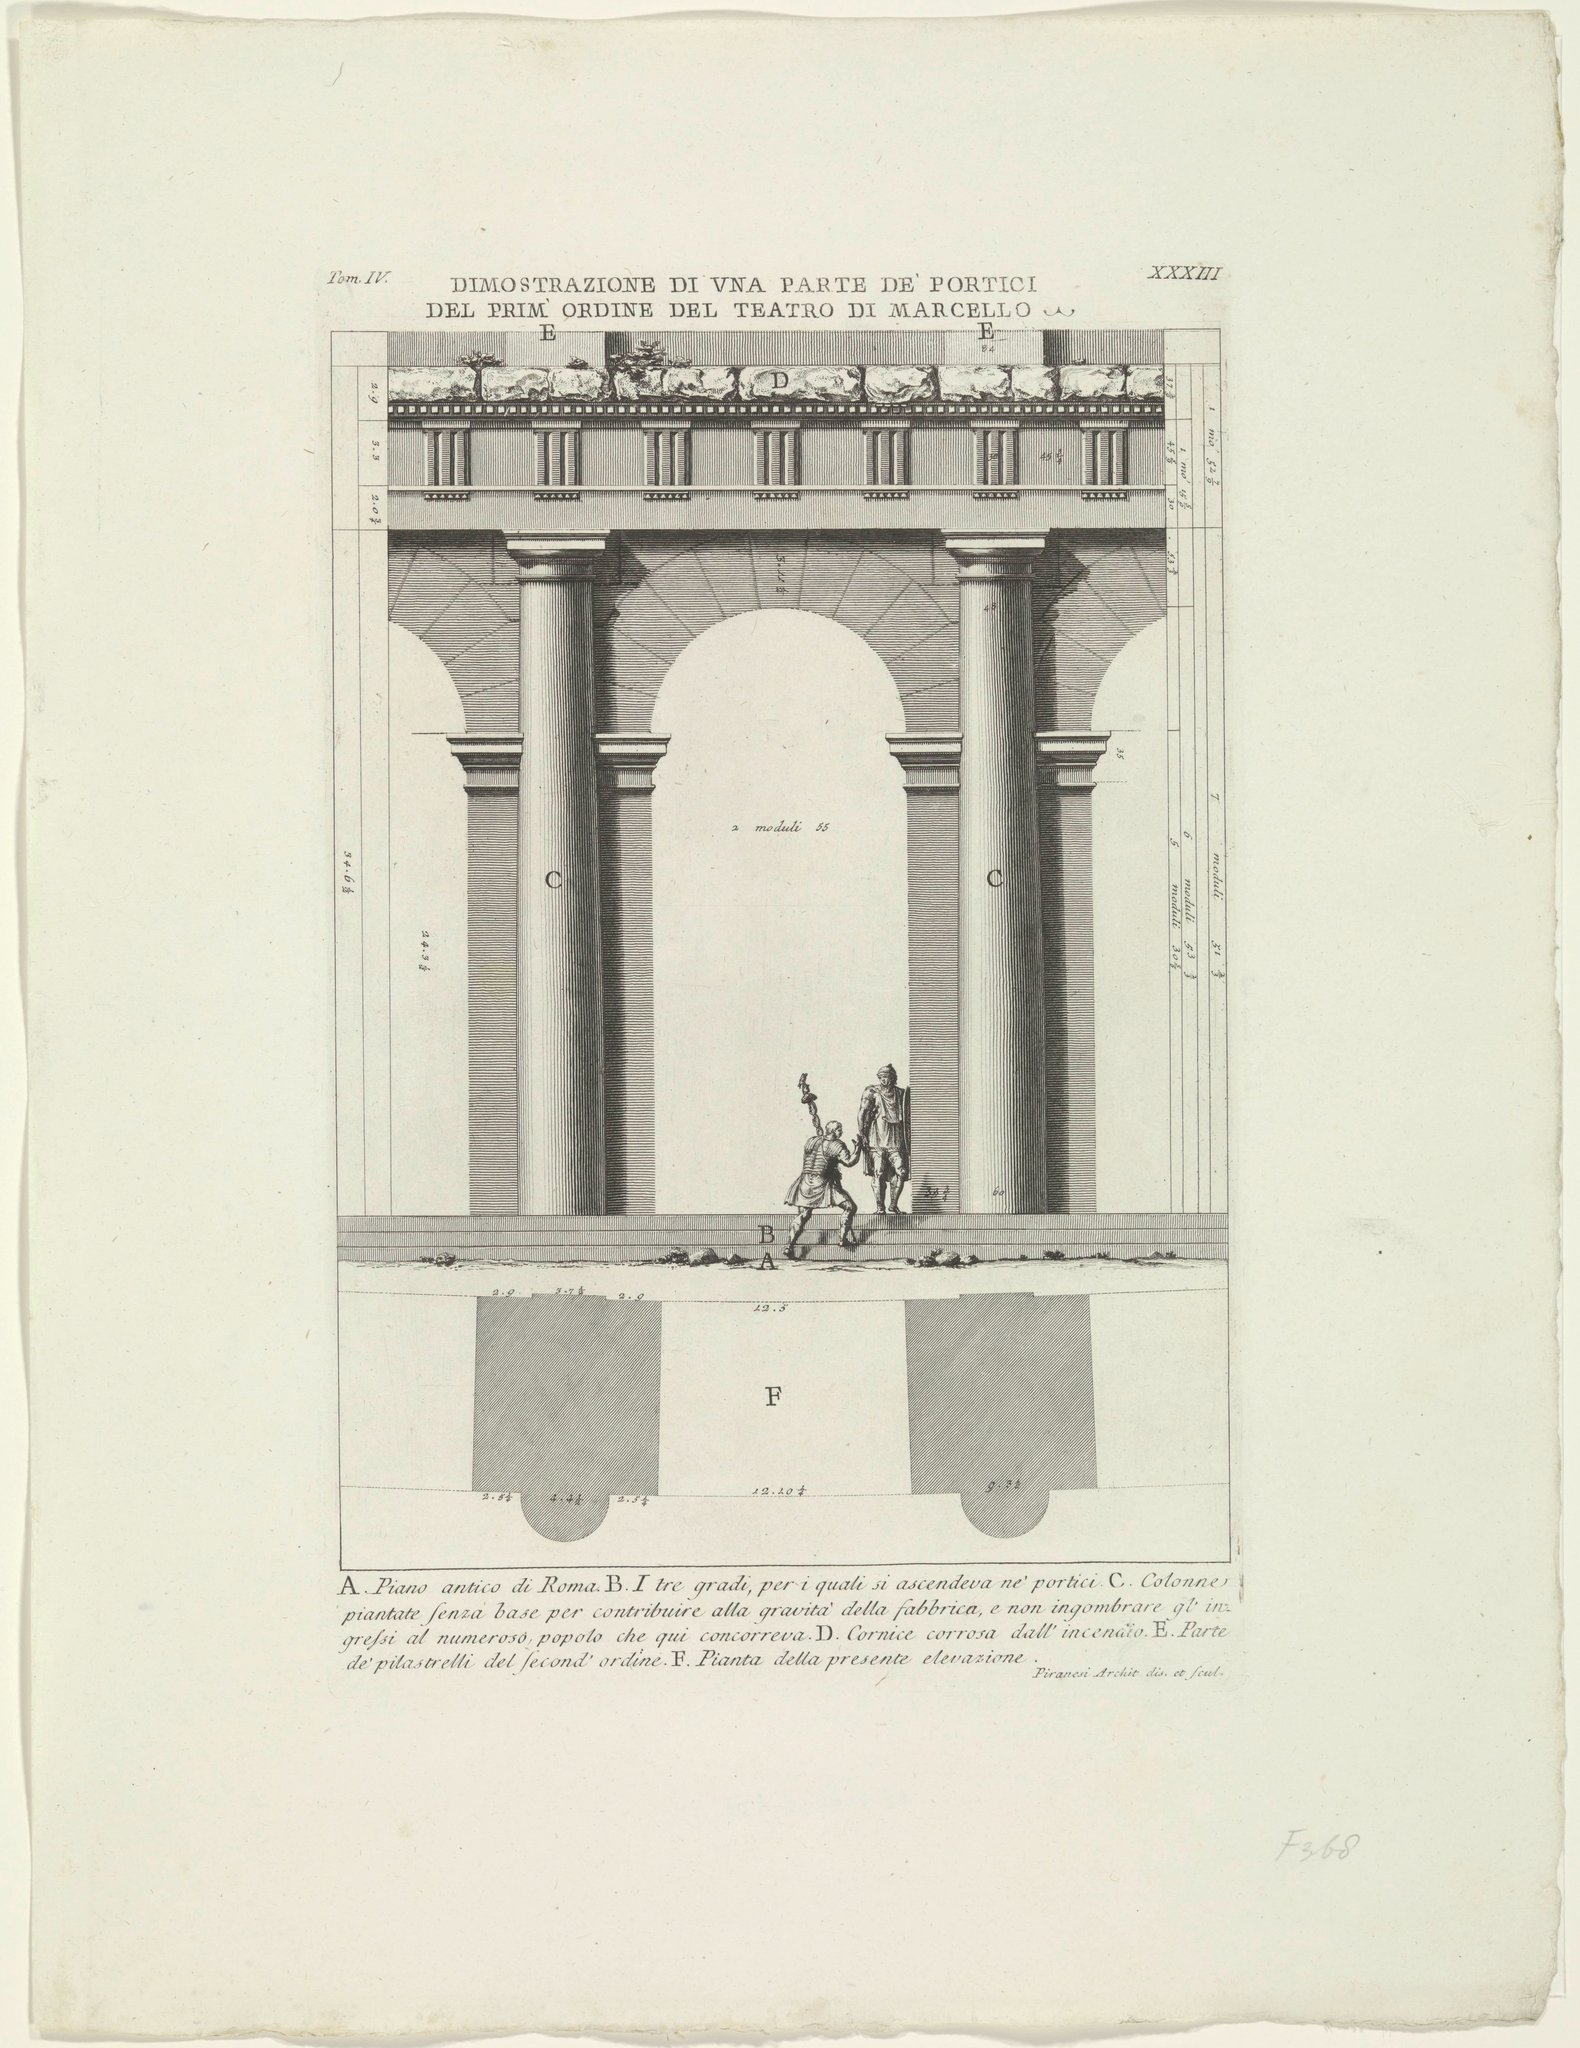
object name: print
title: Archeologische vondsten in en rond Rome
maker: giovanni battista piranesi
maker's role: designer, draughtsman, print maker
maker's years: 1720-1778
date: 1756-1757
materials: paper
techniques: etching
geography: rome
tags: ruin of a building ~ architecture, theatre (building)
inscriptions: collector's mark: Lugt 2228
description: Deze prent maakt deel uit van de serie 'Le Antichità Romane'. Piranesi deed meer dan acht jaar voorstudie voor deze 250 platen tellende serie die in vier volumes werd uitgegeven. Hij produceerde de prenten tussen ca. 1756 en 1757. De serie bevat ook prenten door of naar andere prentmakers, onder wie Francesco Bianchini en Girolamo Rossi.